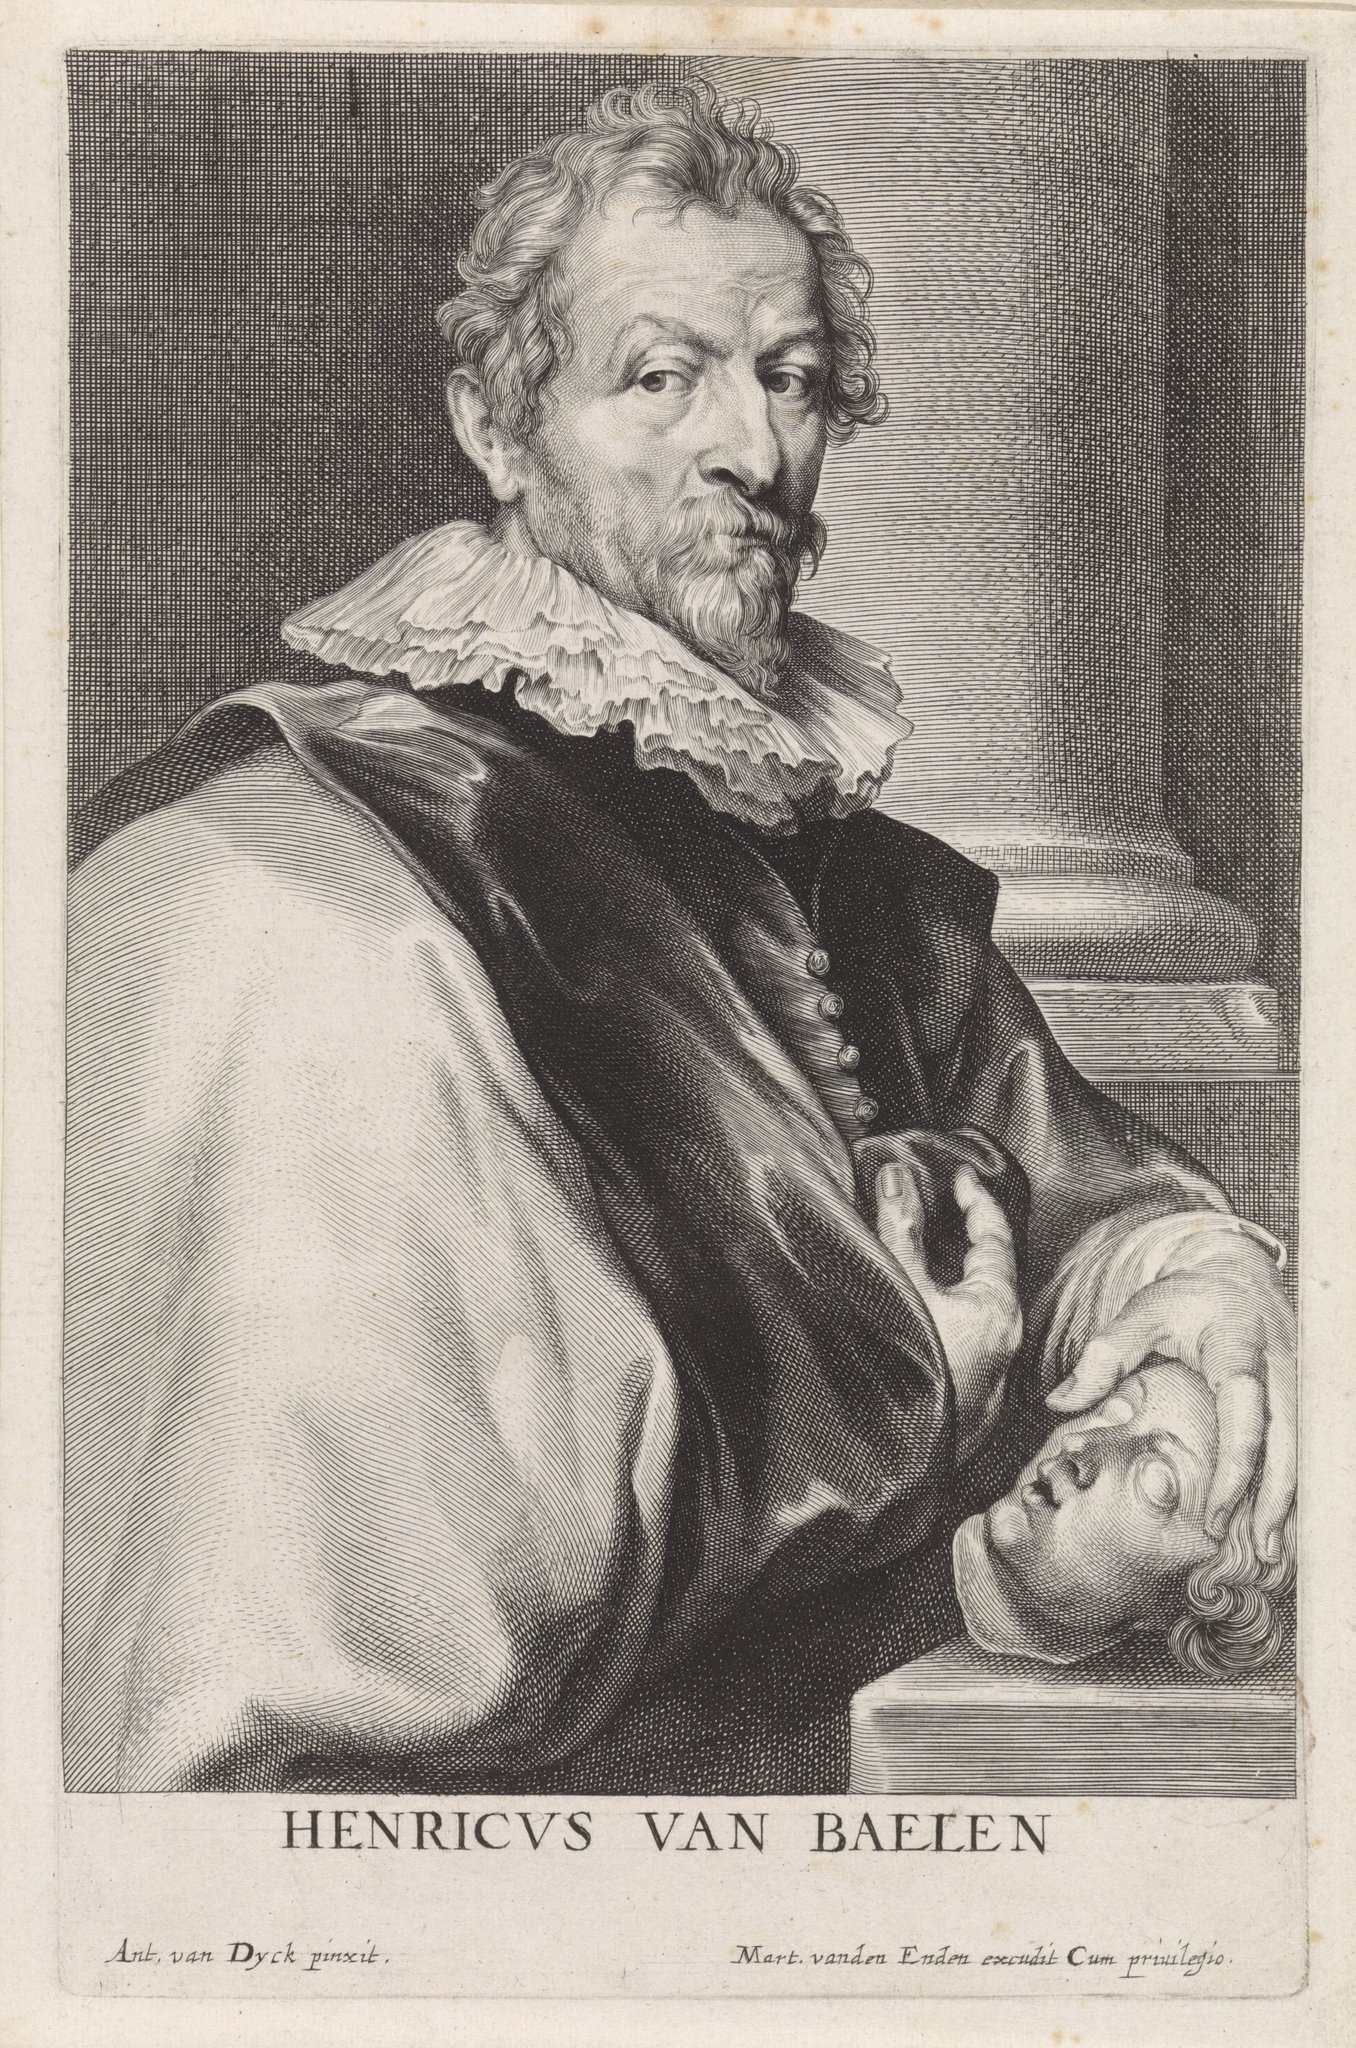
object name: print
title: Portret van de schilder Hendrik van Balen (I)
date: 1616-1657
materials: paper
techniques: engraving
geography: antwerp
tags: painter, hendrik van balen (i), portrait, self-portrait of painter, piece of sculpture, reproduction of a piece of sculpture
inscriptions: collector's mark: Lugt 240